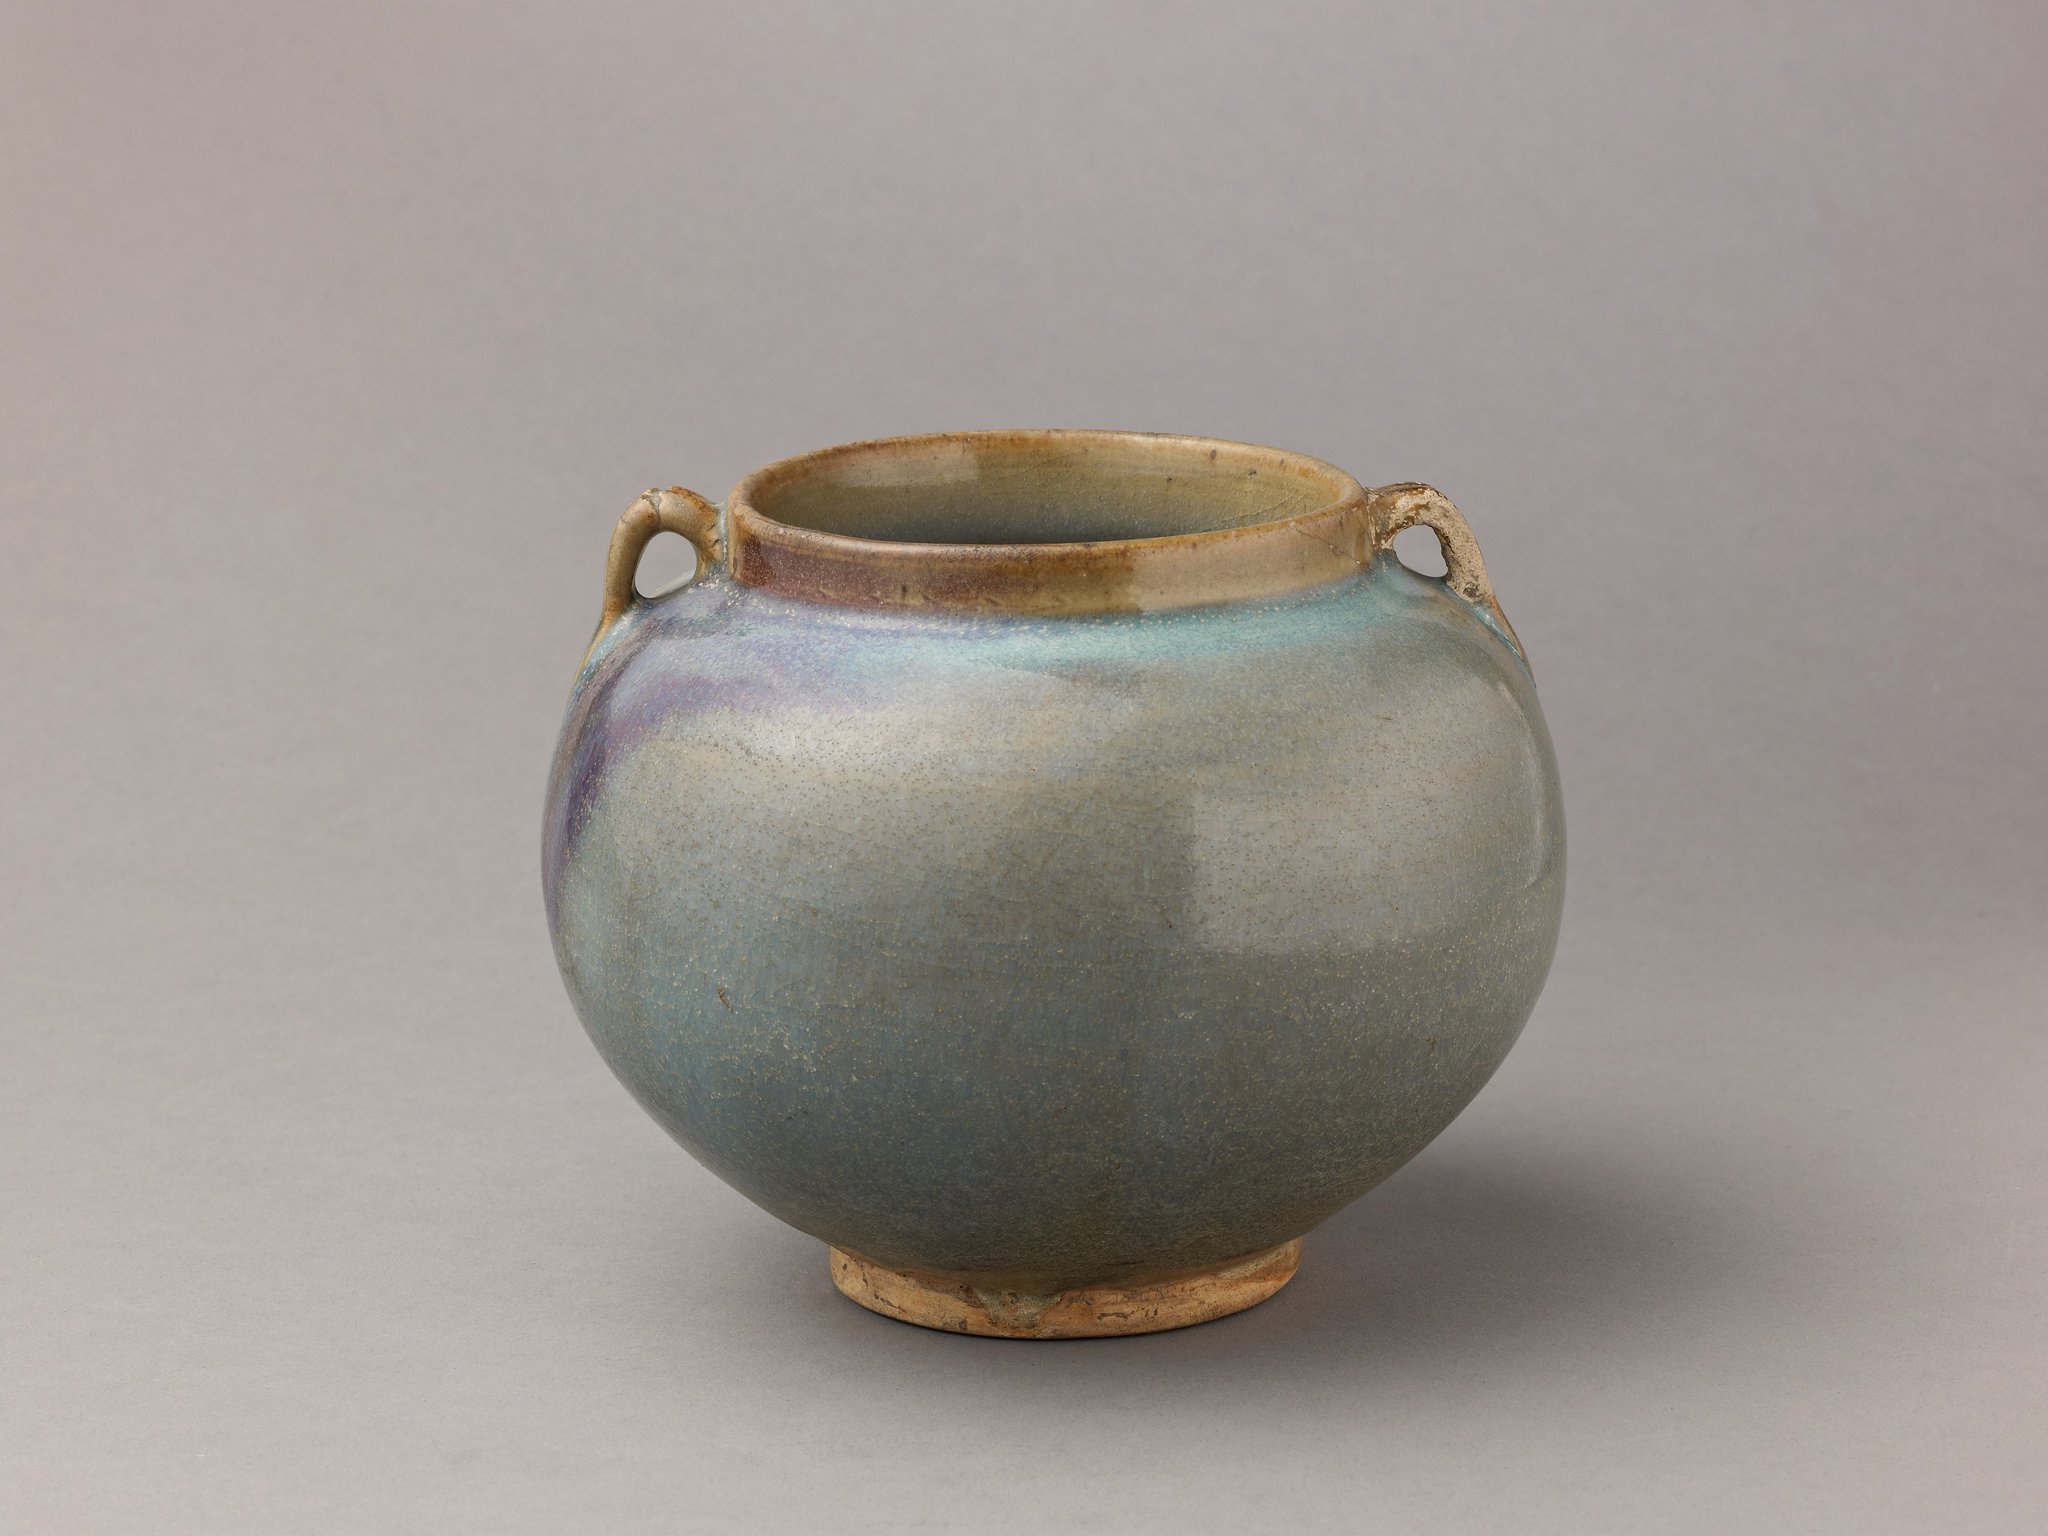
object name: jar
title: Two-eared jar, Jun ware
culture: chinese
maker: chinese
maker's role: artist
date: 1201-1300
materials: glaze, stoneware